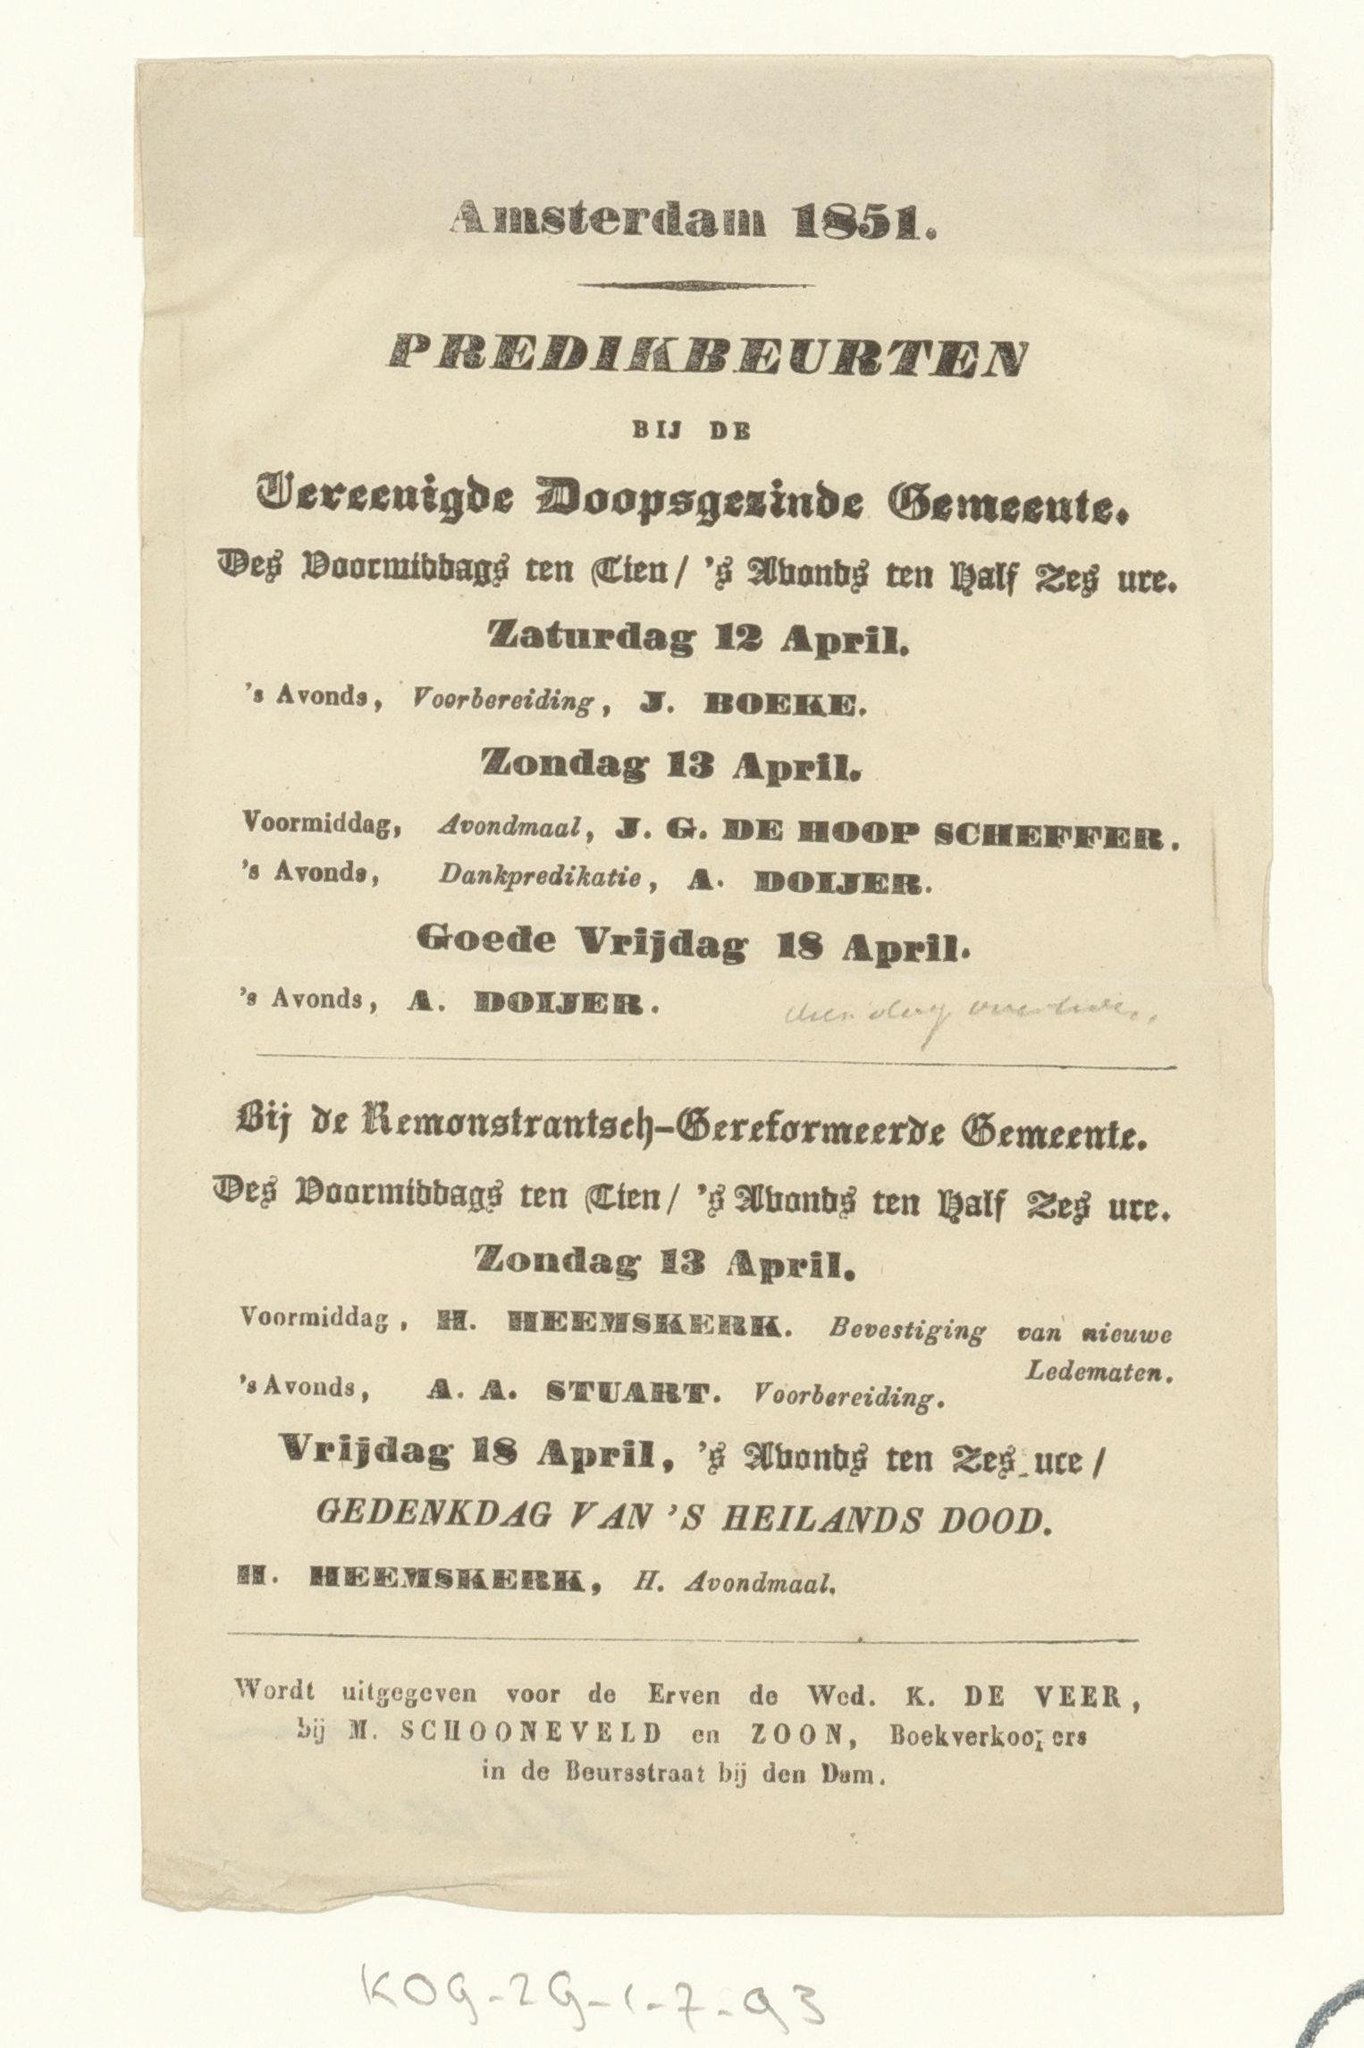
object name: text sheet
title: Preken van de Vereenigde Doopsgezinde Gemeente in april 1851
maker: Anonymous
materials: paper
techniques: letterpress printing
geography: amsterdam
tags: preaching (in general)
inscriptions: collector's mark: Lugt 1641, stamp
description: Preken van de Vereenigde Doopsgezinde Gemeente in april 1851 in Amsterdam. Bij de preken staan de namen van de predikanten. Onderwerpsrubrieken binnen de Atlas Zeden en Gewoonten: Godsdienst, Predikbeurtenlijstjes.